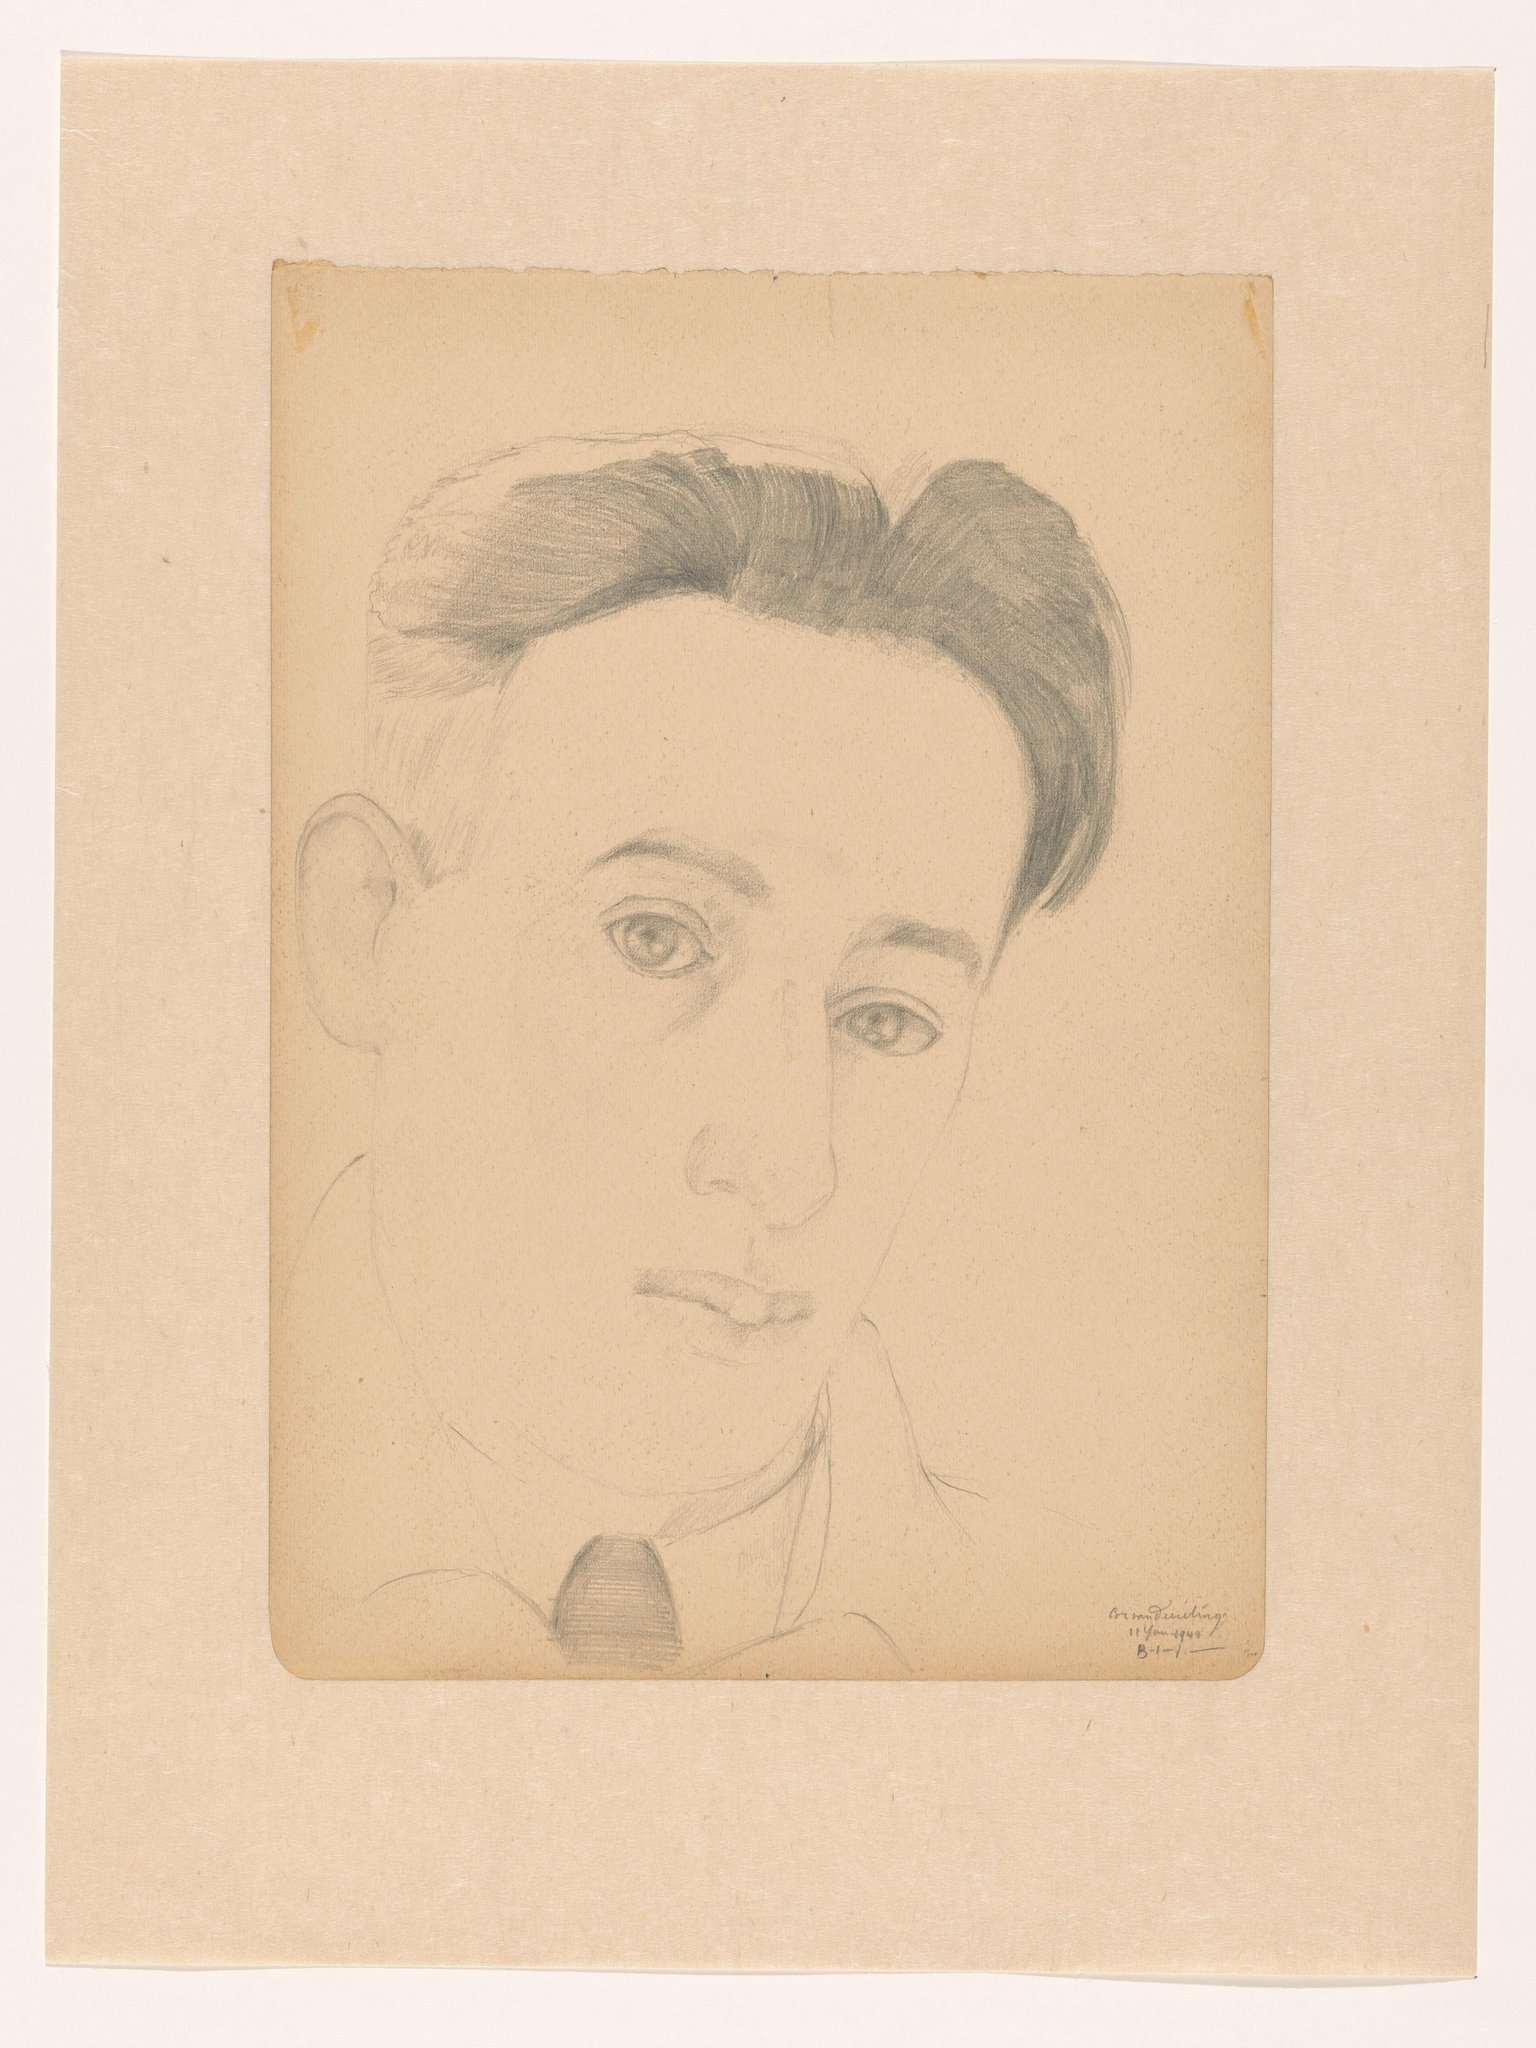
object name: drawing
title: Zelfportretten van Cor van Teeseling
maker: cor van teeseling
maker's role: draughtsman, sculptor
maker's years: 1915-1942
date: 1942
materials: paper, pencil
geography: weteringschans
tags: amsterdam, draughtsman, sculptor, cor van teeseling, historical persons, prisoner in cell or locked place, portrait, self-portrait of draughtsman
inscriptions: signature and date: ‘Cor van Teeseling / 11 Jan 1942 / B-1-1’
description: Zelfportret van Cor van Teeseling: in de gevangenis aan de Weteringschans, cel B-1-1, 11 januari.